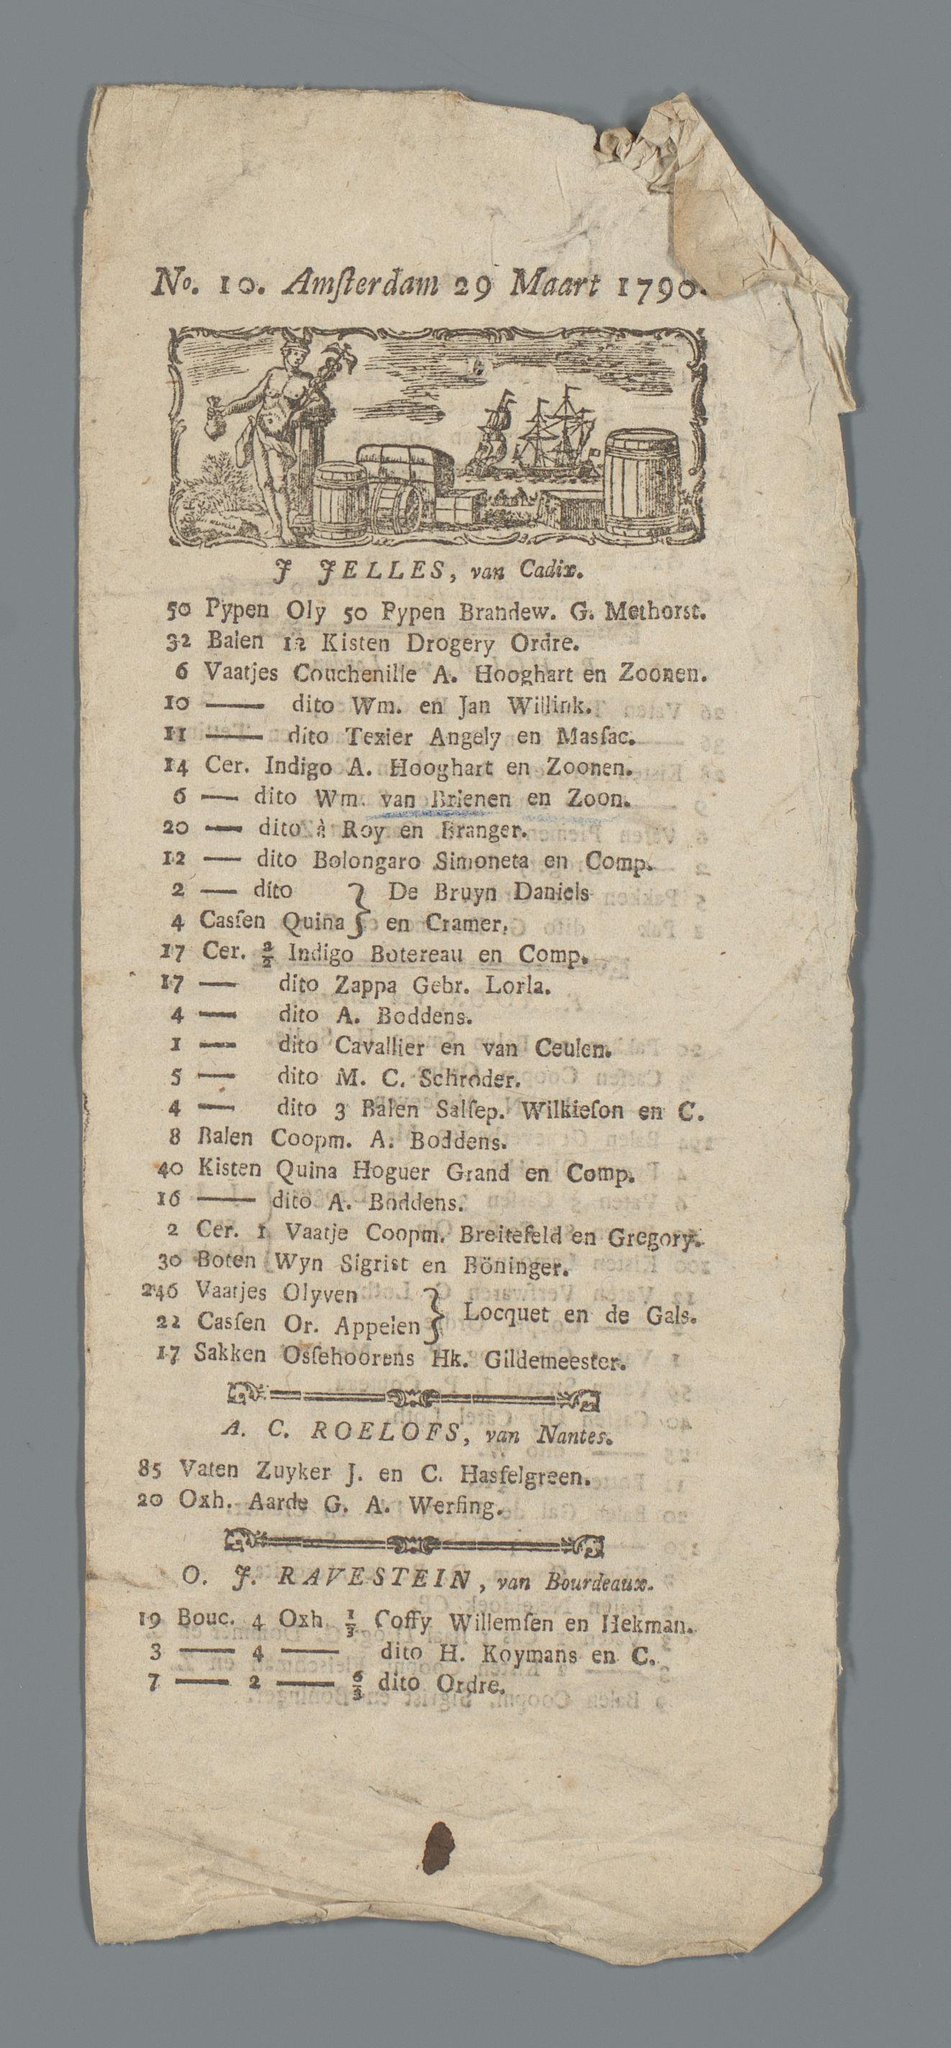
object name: document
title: Scheeps- of beurstijding Nr. 10 Amsterdam 29 Maart 1790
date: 1790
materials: paper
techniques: letterpress printing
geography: amsterdam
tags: specific aspects, allegorical aspects of mercury; mercury as patron, merchant shipping, shipping trade, merchant, salesman, amsterdam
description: Scheeps- of beurstijdingen met lijst van de kapiteins met de plaats waar ze vandaan kwamen en wat ze hebben aangevoerd. Dubbelgevouwen blad met tekst, genummerd p. 37-40. Voorzijde bovenaan een vignet met Mercurius op de kade tussen koopwaar, schepen op de achtergrond.